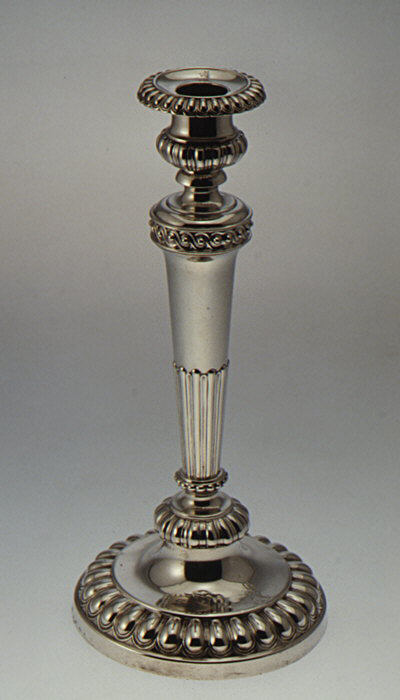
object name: candlestick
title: Set of four candlesticks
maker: matthew boulton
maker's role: maker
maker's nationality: british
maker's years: 1728-1809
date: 1806-1808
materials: silver